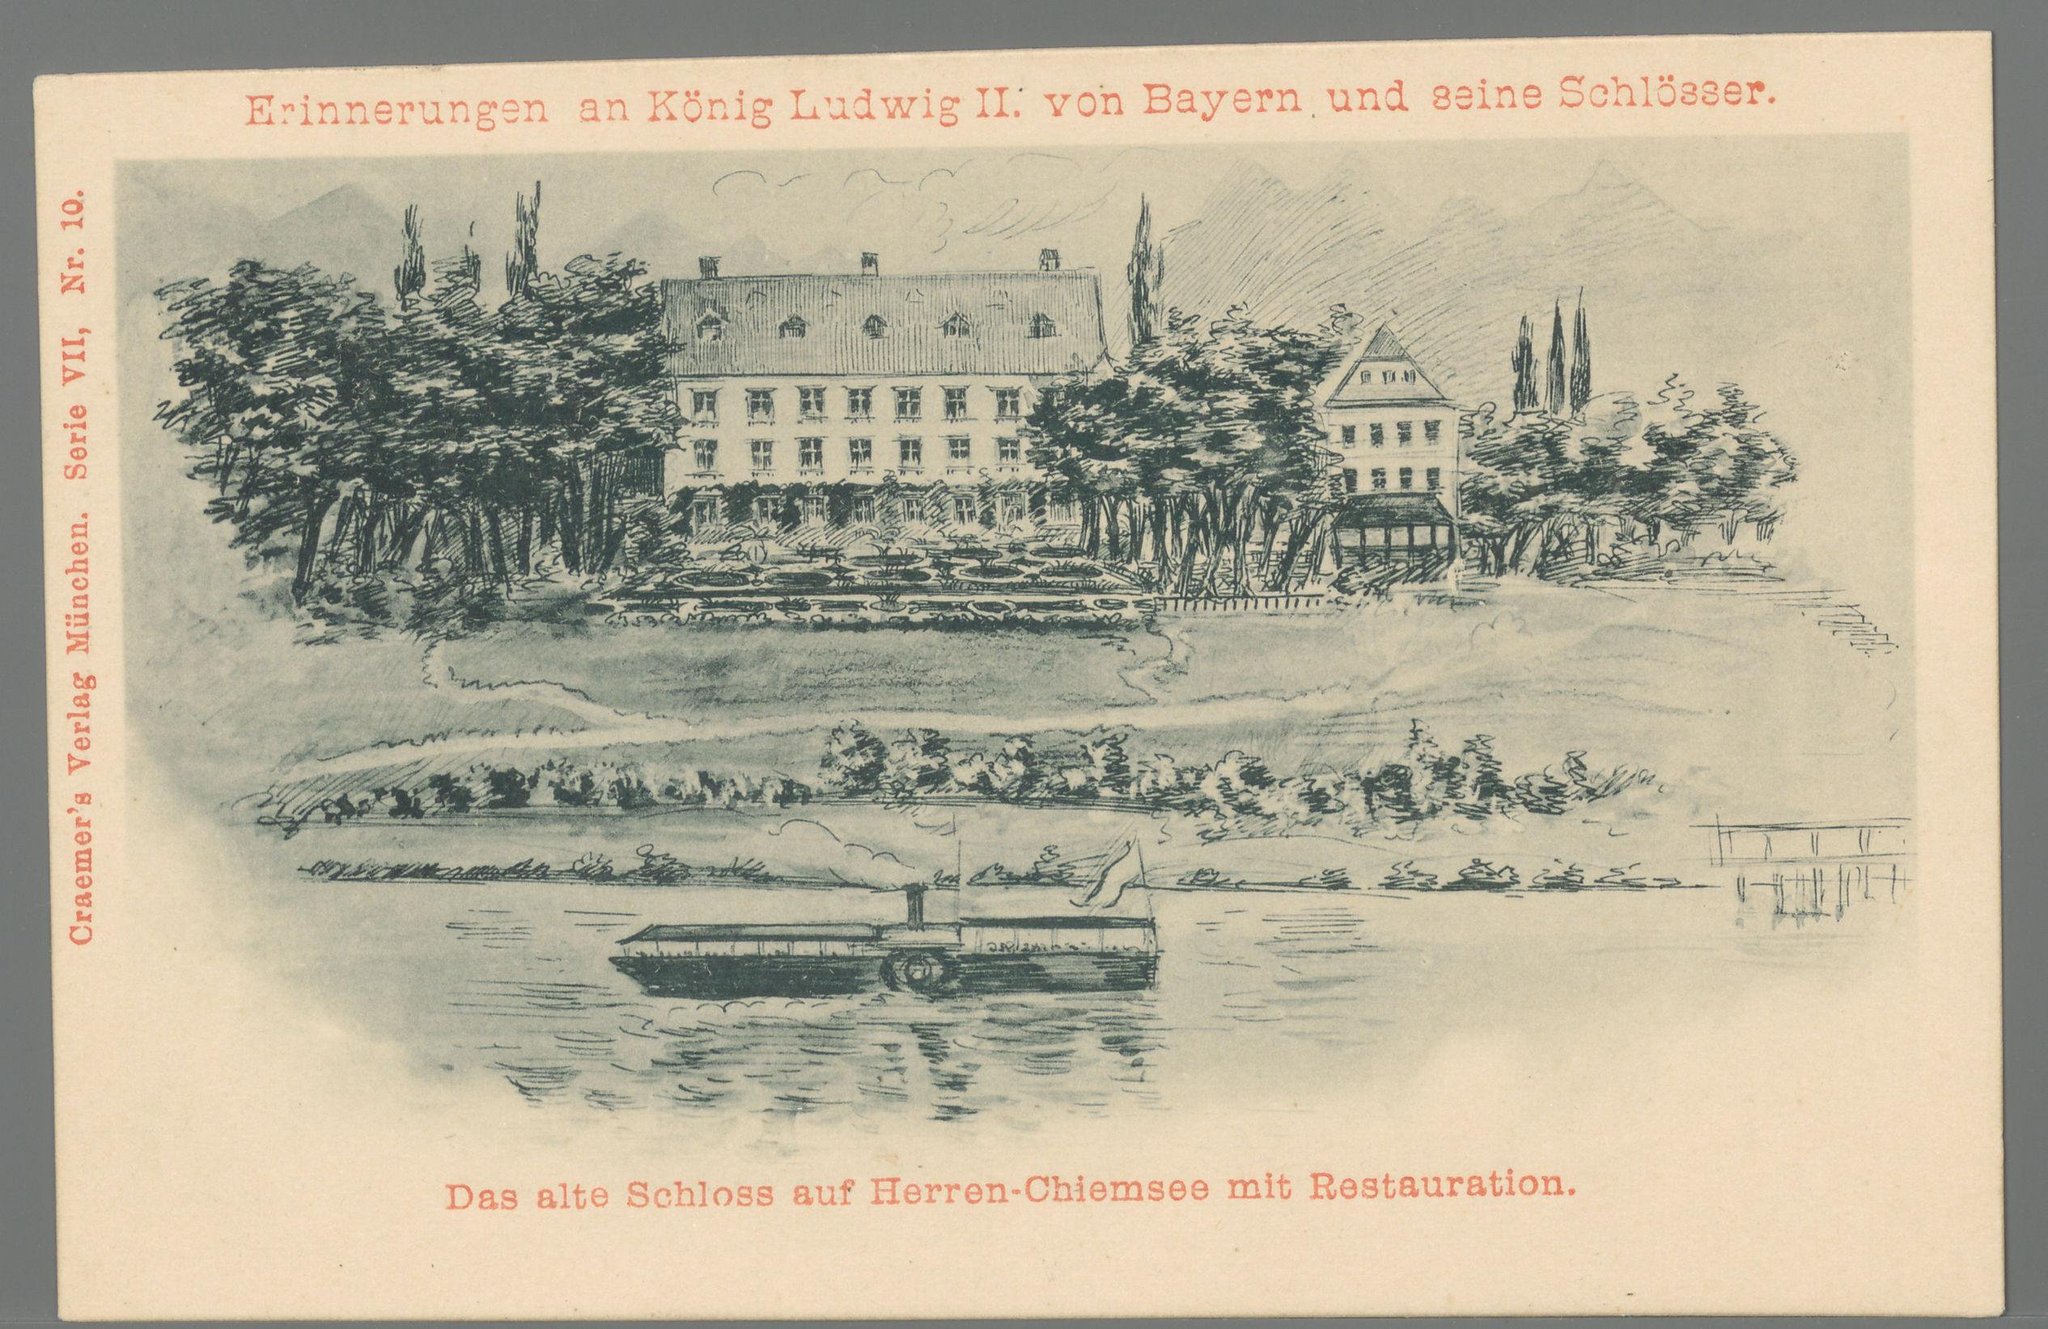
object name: photomechanical print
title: Erinnerungen an König Ludwig II. von Bayern und seine Schlösser.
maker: Anonymous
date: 1886-1905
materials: cardboard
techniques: photograph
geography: munich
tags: landscape with tower or castle